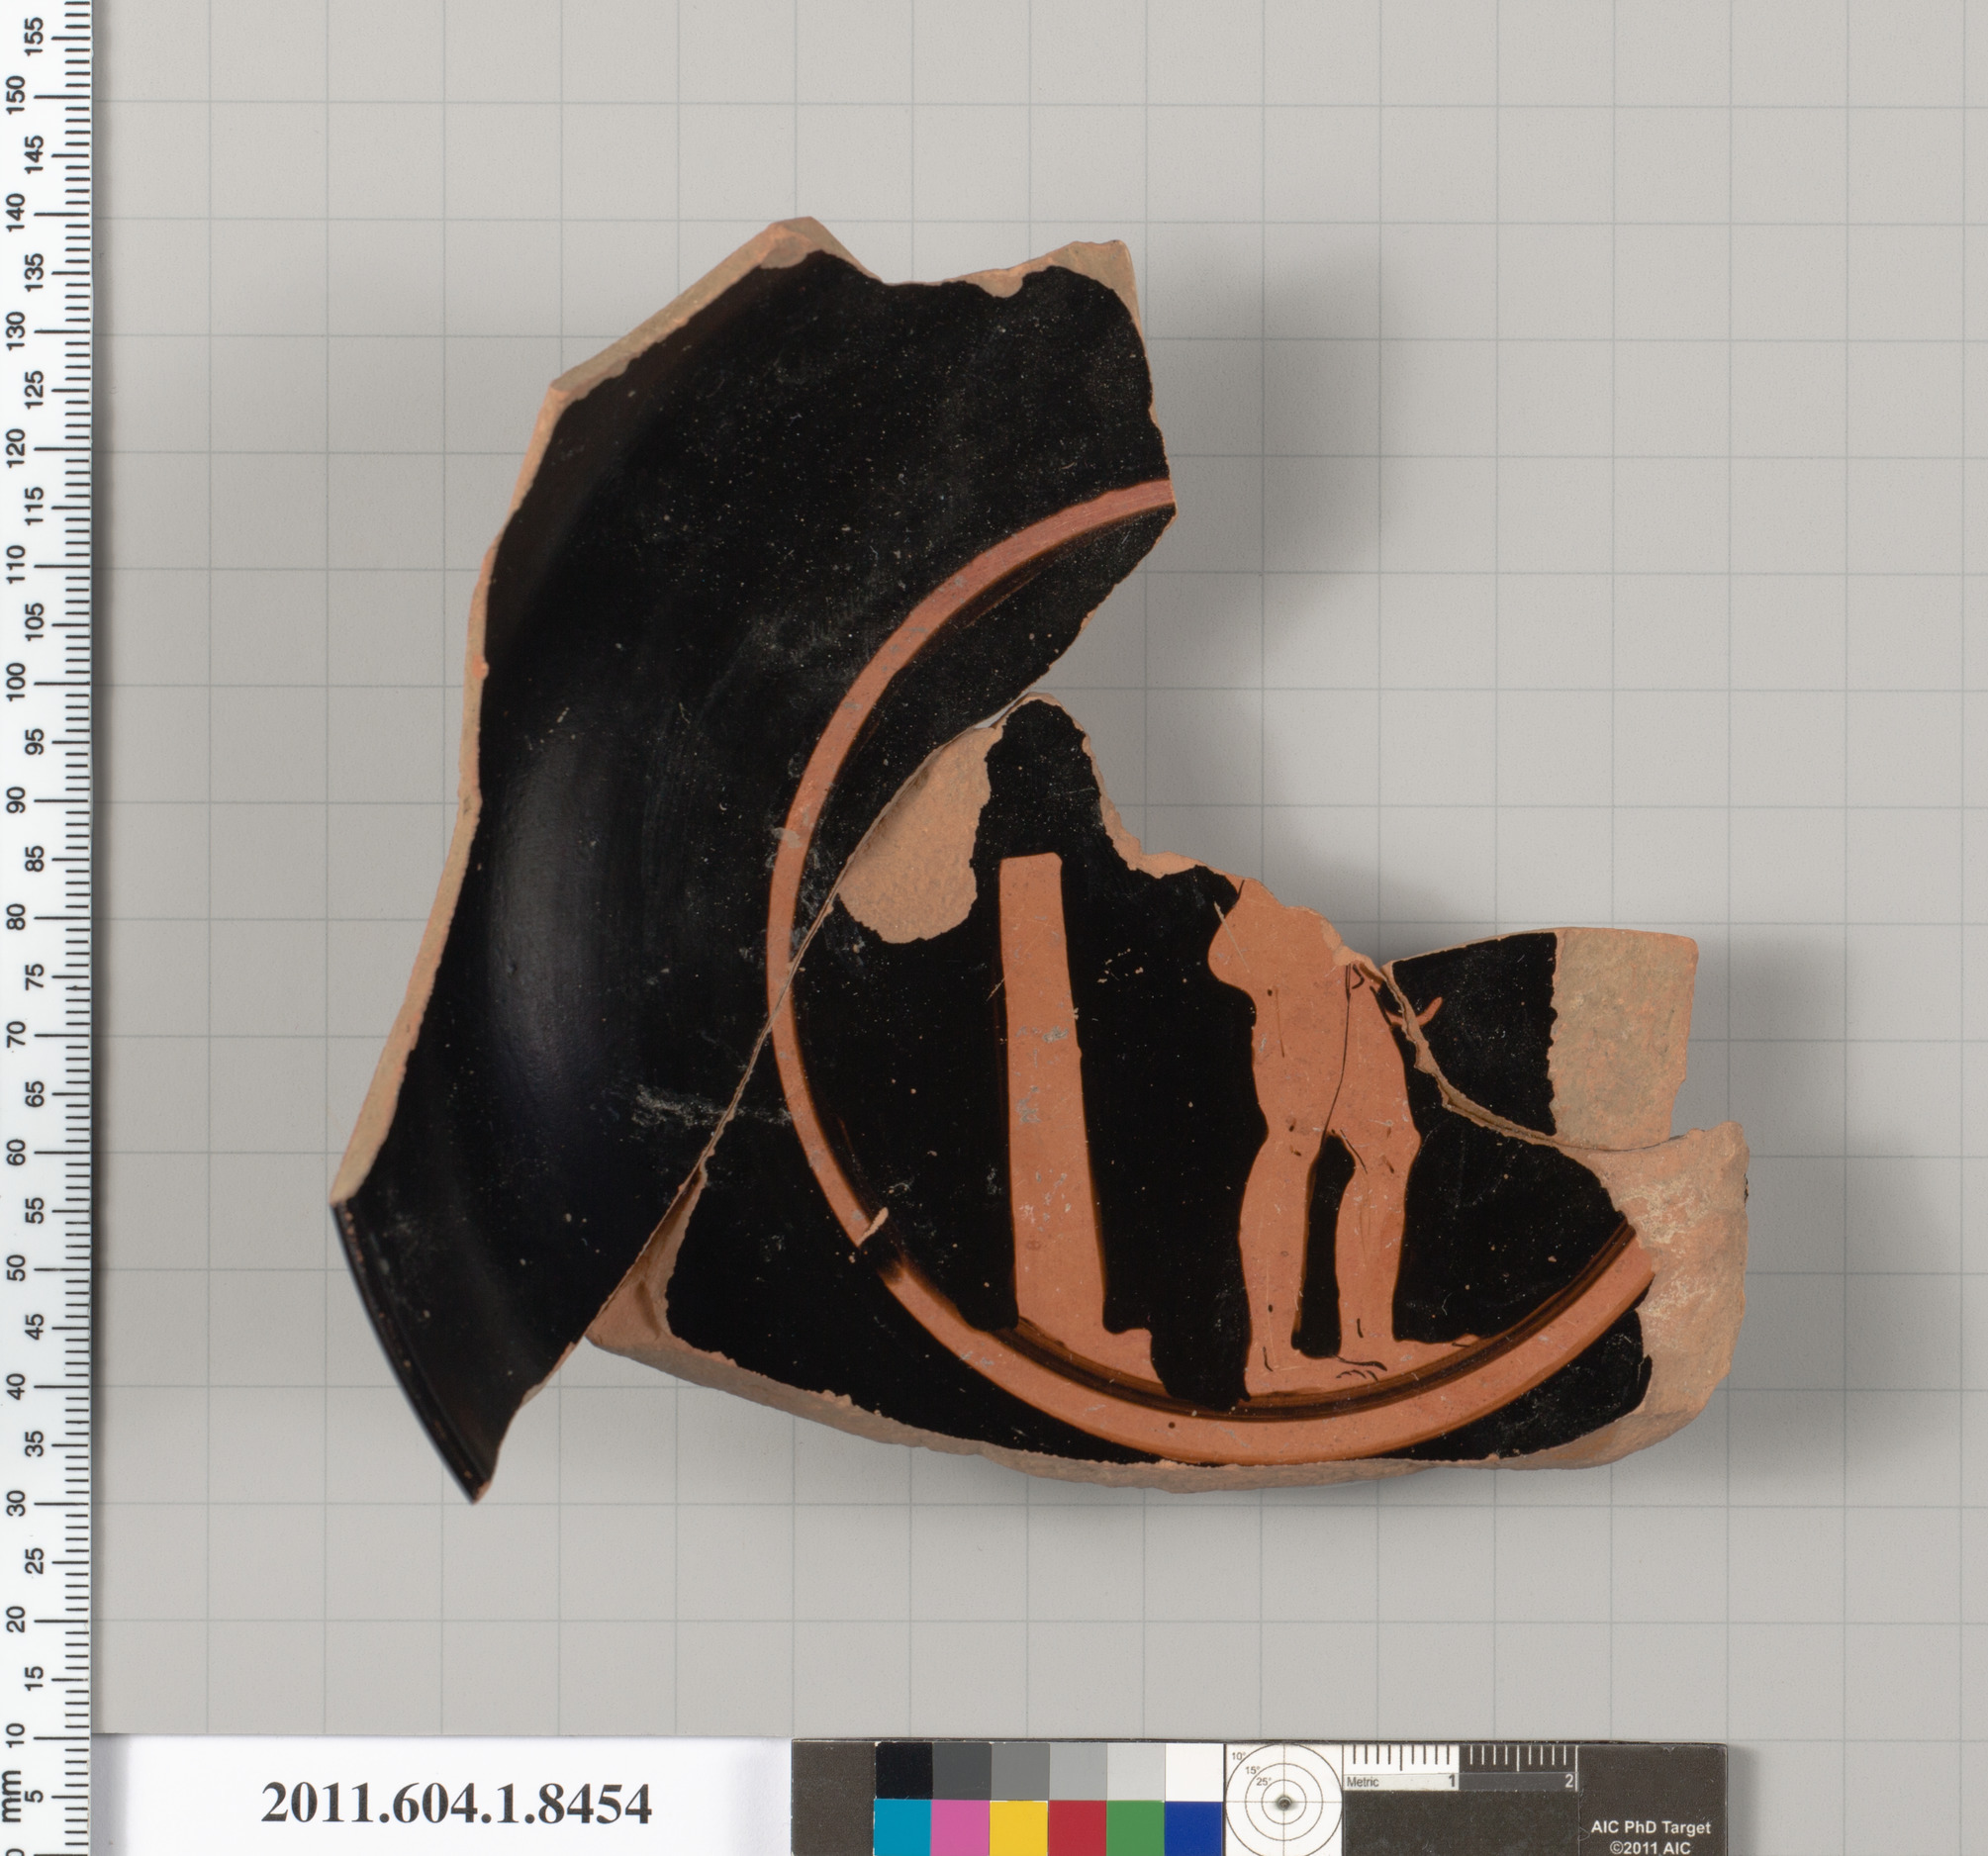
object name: kylix fragment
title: Terracotta fragment of a stemless kylix (drinking cup)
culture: greek, attic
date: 460-450 BCE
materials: terracotta